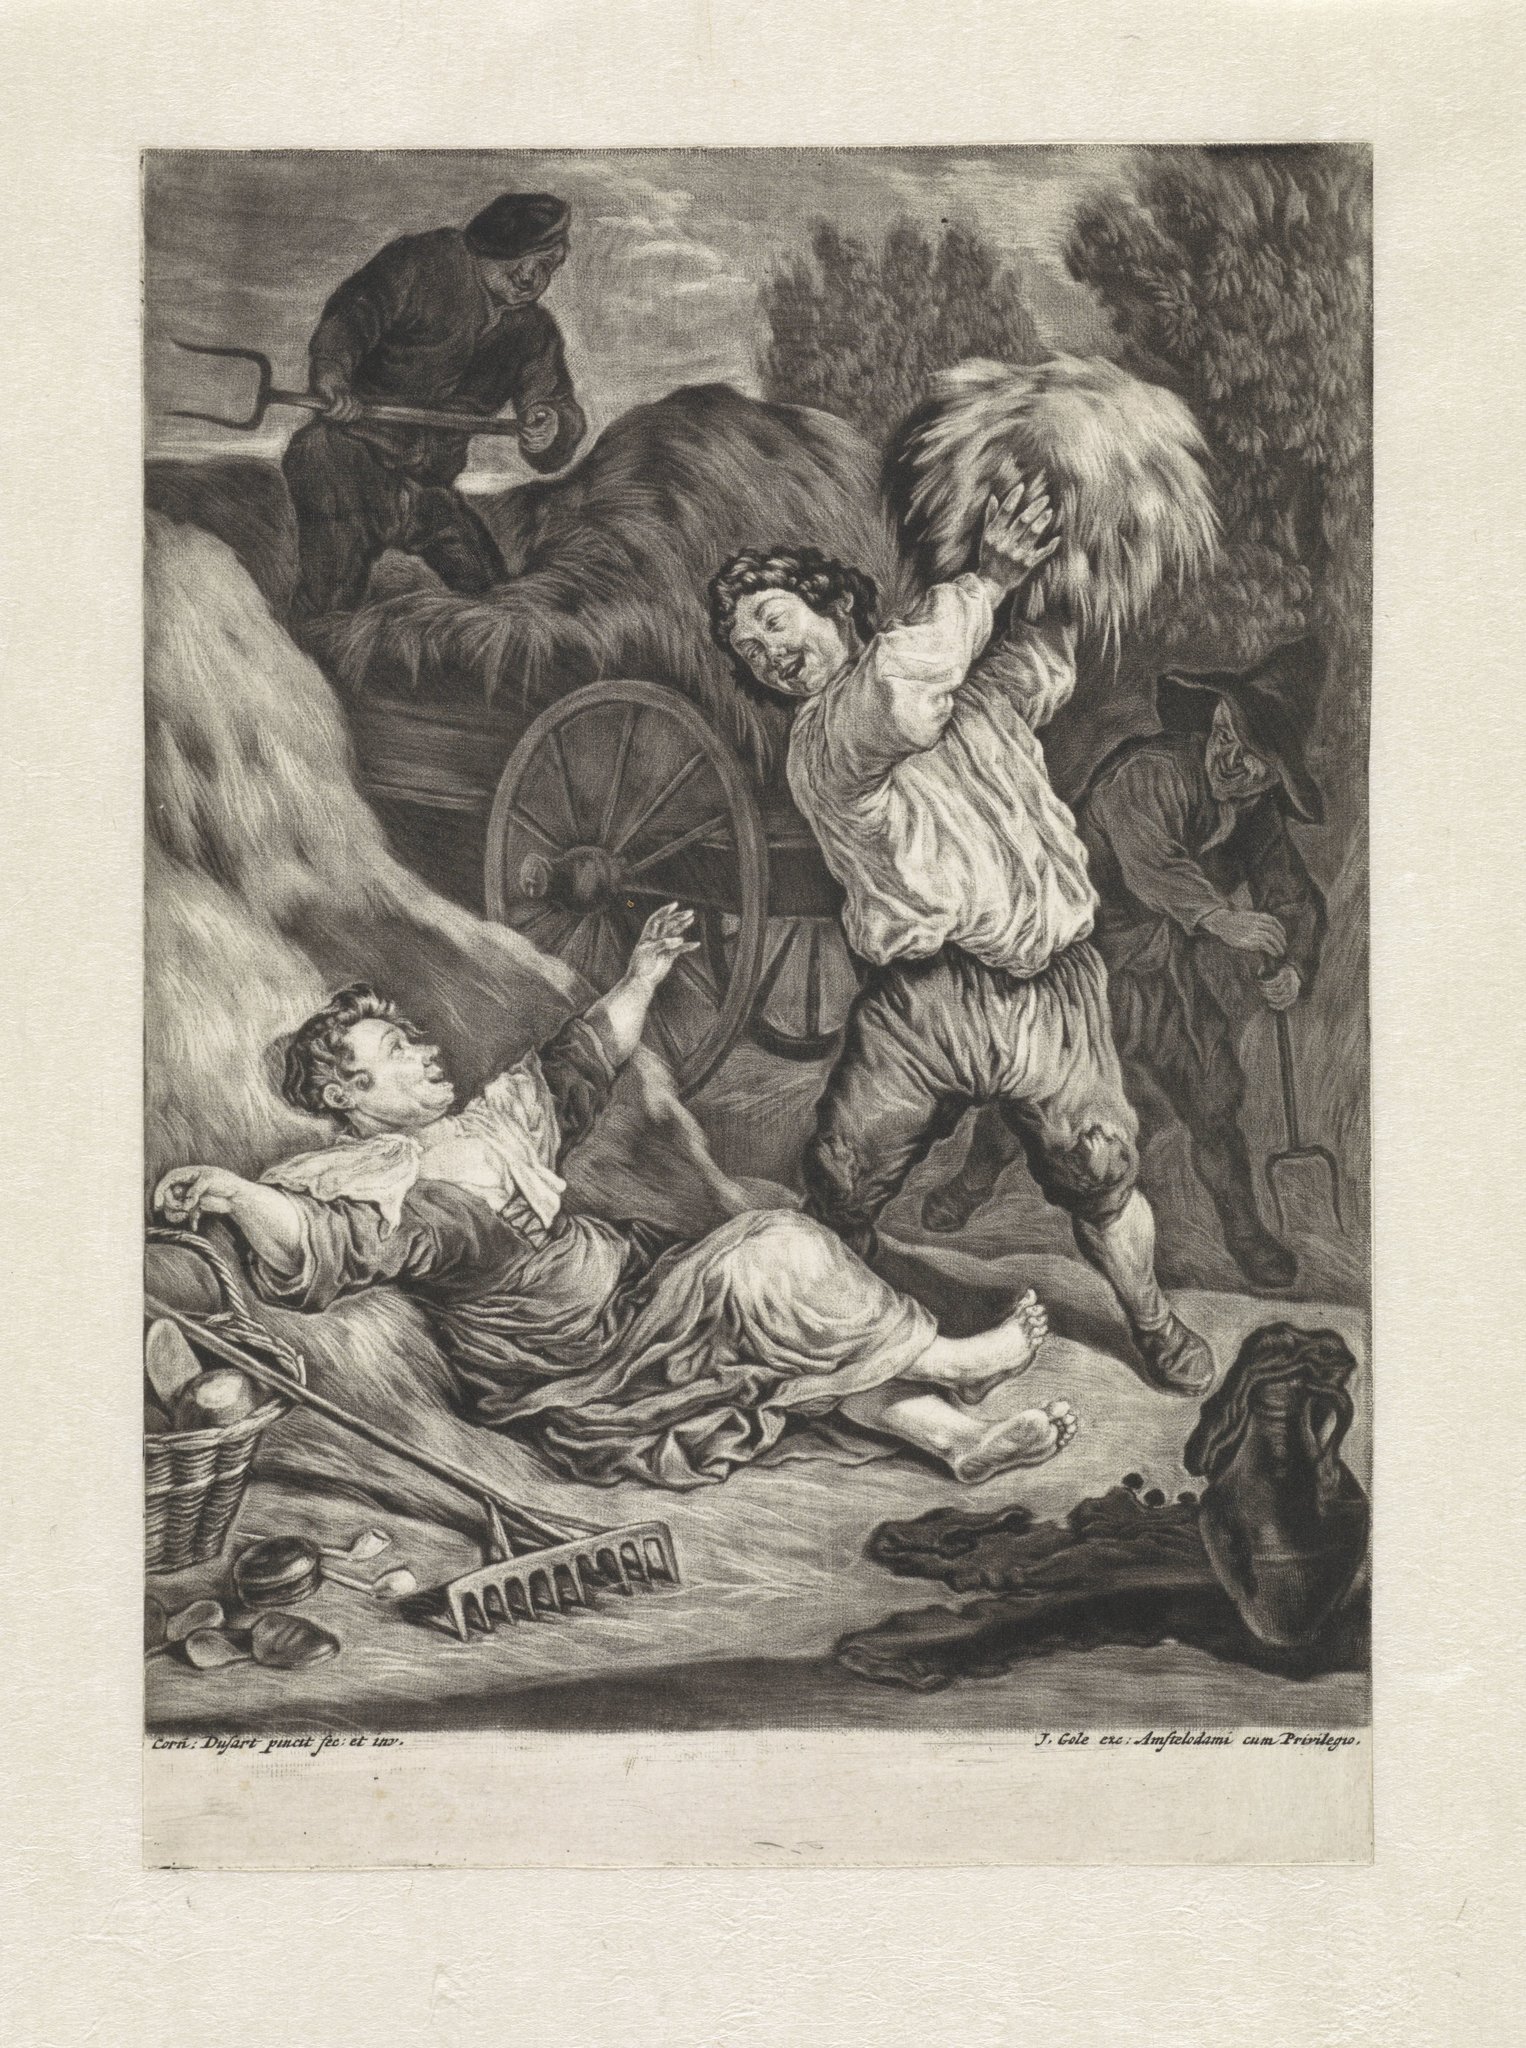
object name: print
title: De twaalf maanden van het jaar, "Les XII Mois de l'Année"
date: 1679-1704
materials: paper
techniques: engraving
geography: amsterdam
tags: july and its 'labours', hay-stack, hay-wagon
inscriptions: collector's mark: Lugt 240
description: Oogsttafereel met pretmakende boeren. Een van de boeren staat op het punt om een bundel hooi op een tegen een hooistapel gelegen vrouw te werpen. De prent maakt deel uit van een serie van twaalf prenten met de twaalf maanden van het jaar.